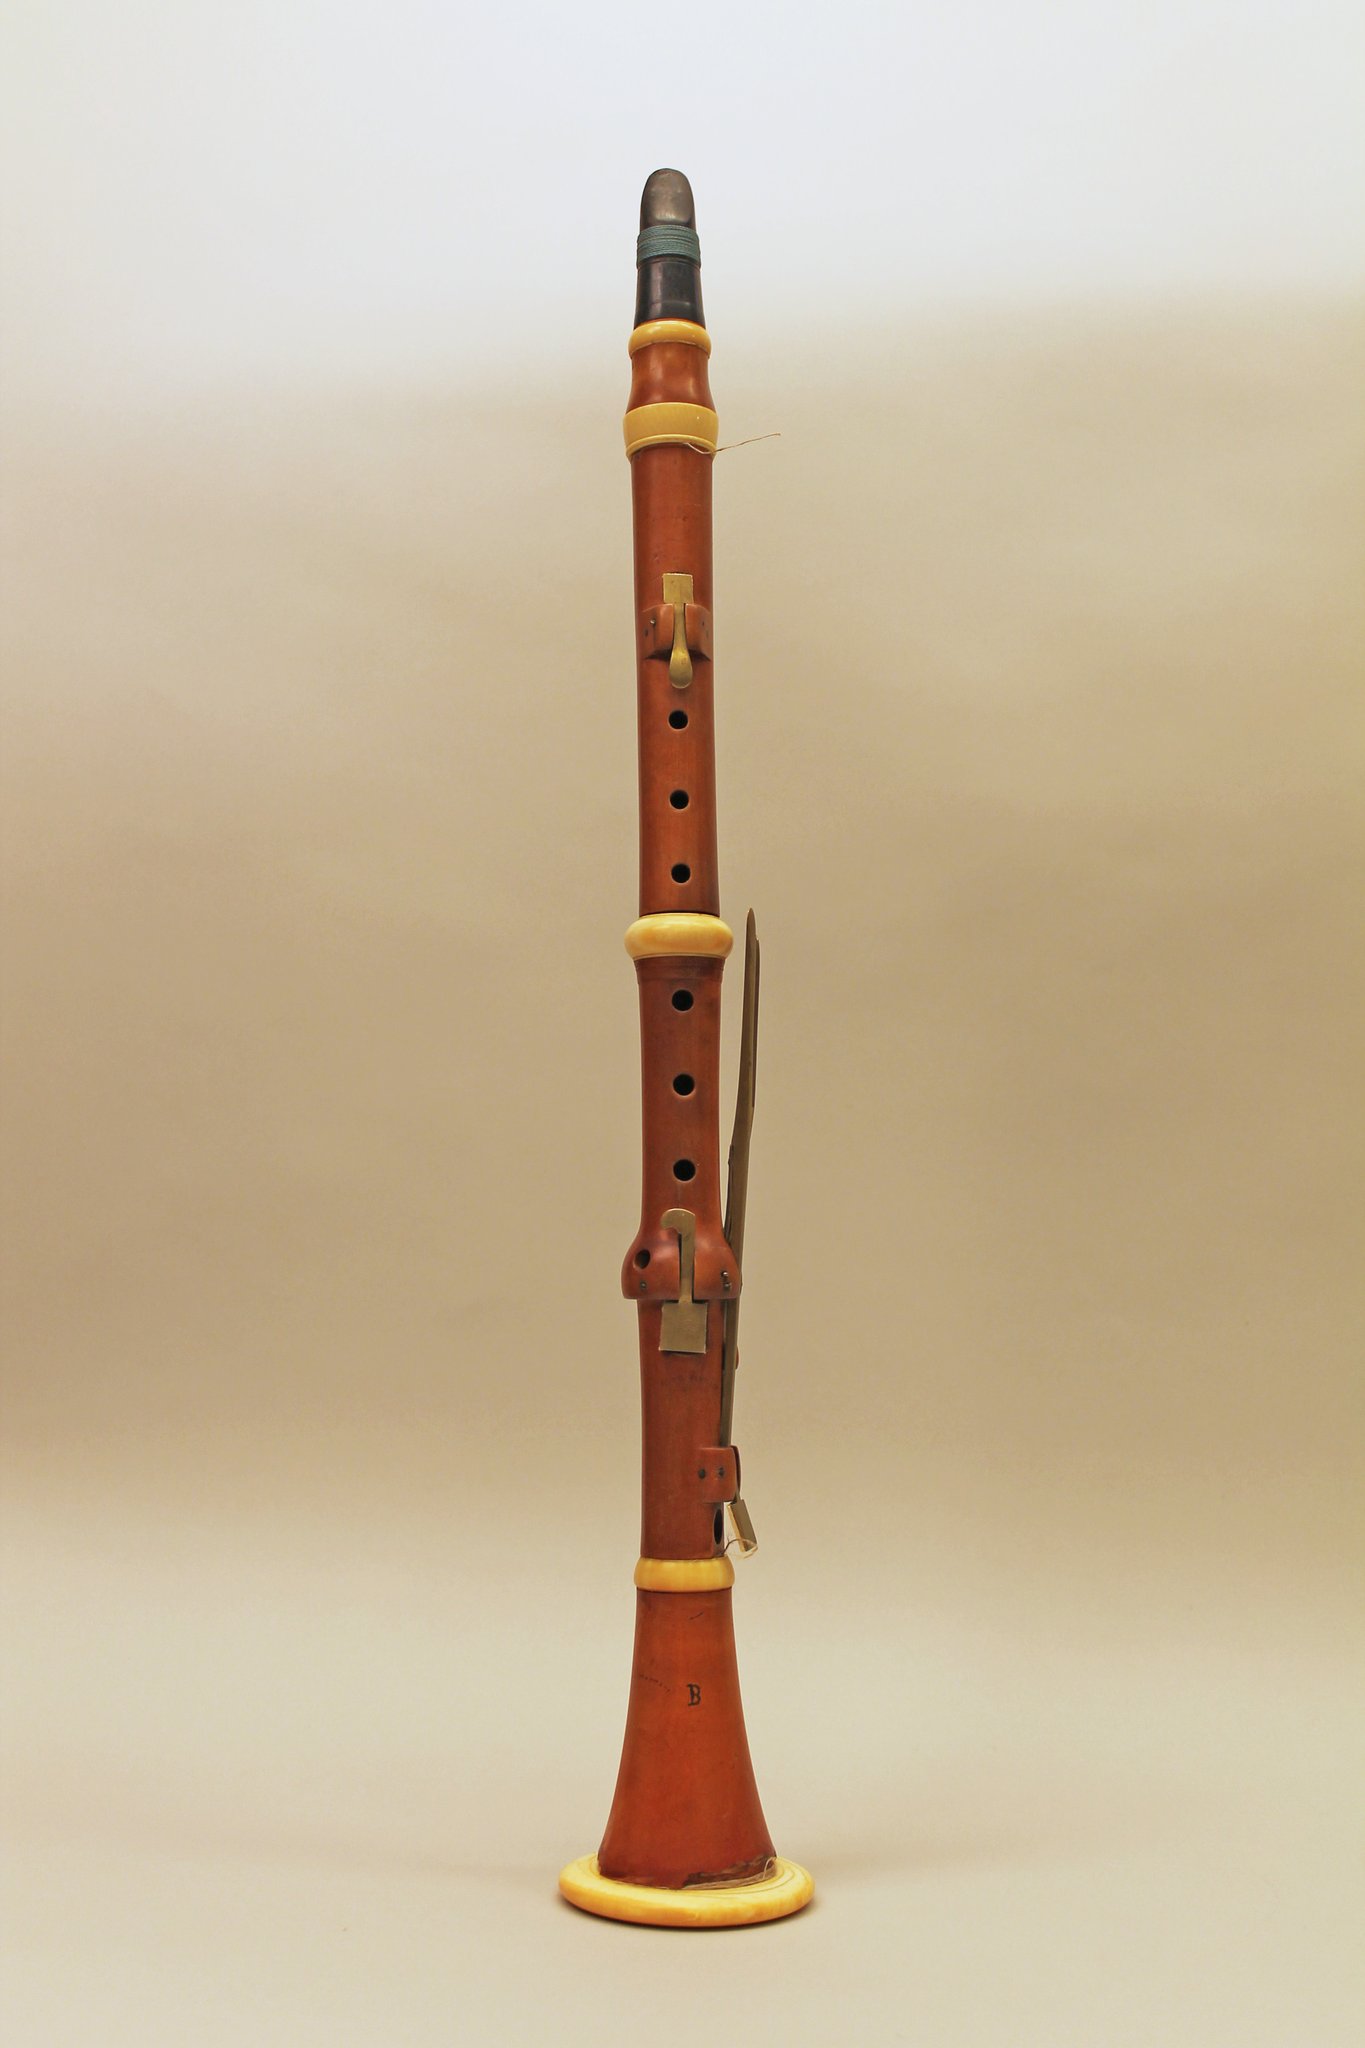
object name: clarinet in b flat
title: Clarinet in B-flat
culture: american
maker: horace meacham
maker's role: maker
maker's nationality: american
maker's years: 1789-1861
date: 1825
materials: wood, brass, ivory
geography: albany